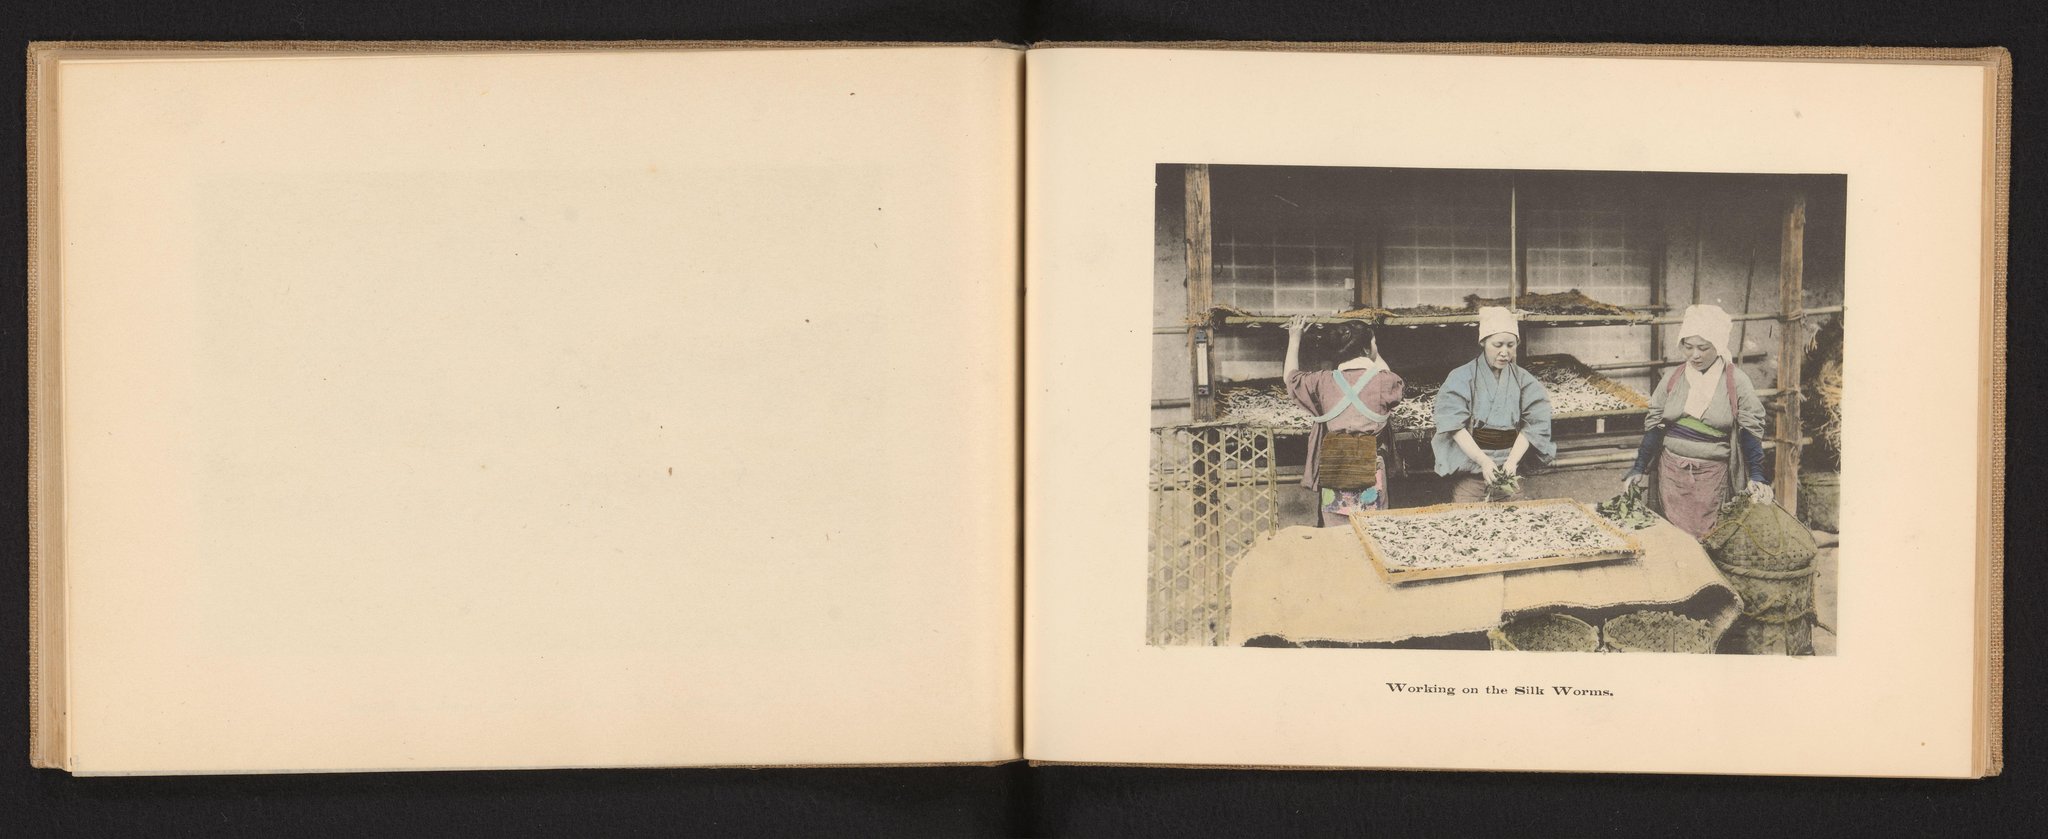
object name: photomechanical print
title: Working on the Silk Worms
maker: kōzaburō tamamura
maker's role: fotograaf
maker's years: 1856-1923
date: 1895-1905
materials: paper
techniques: photograph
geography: japan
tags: silkworm, japan